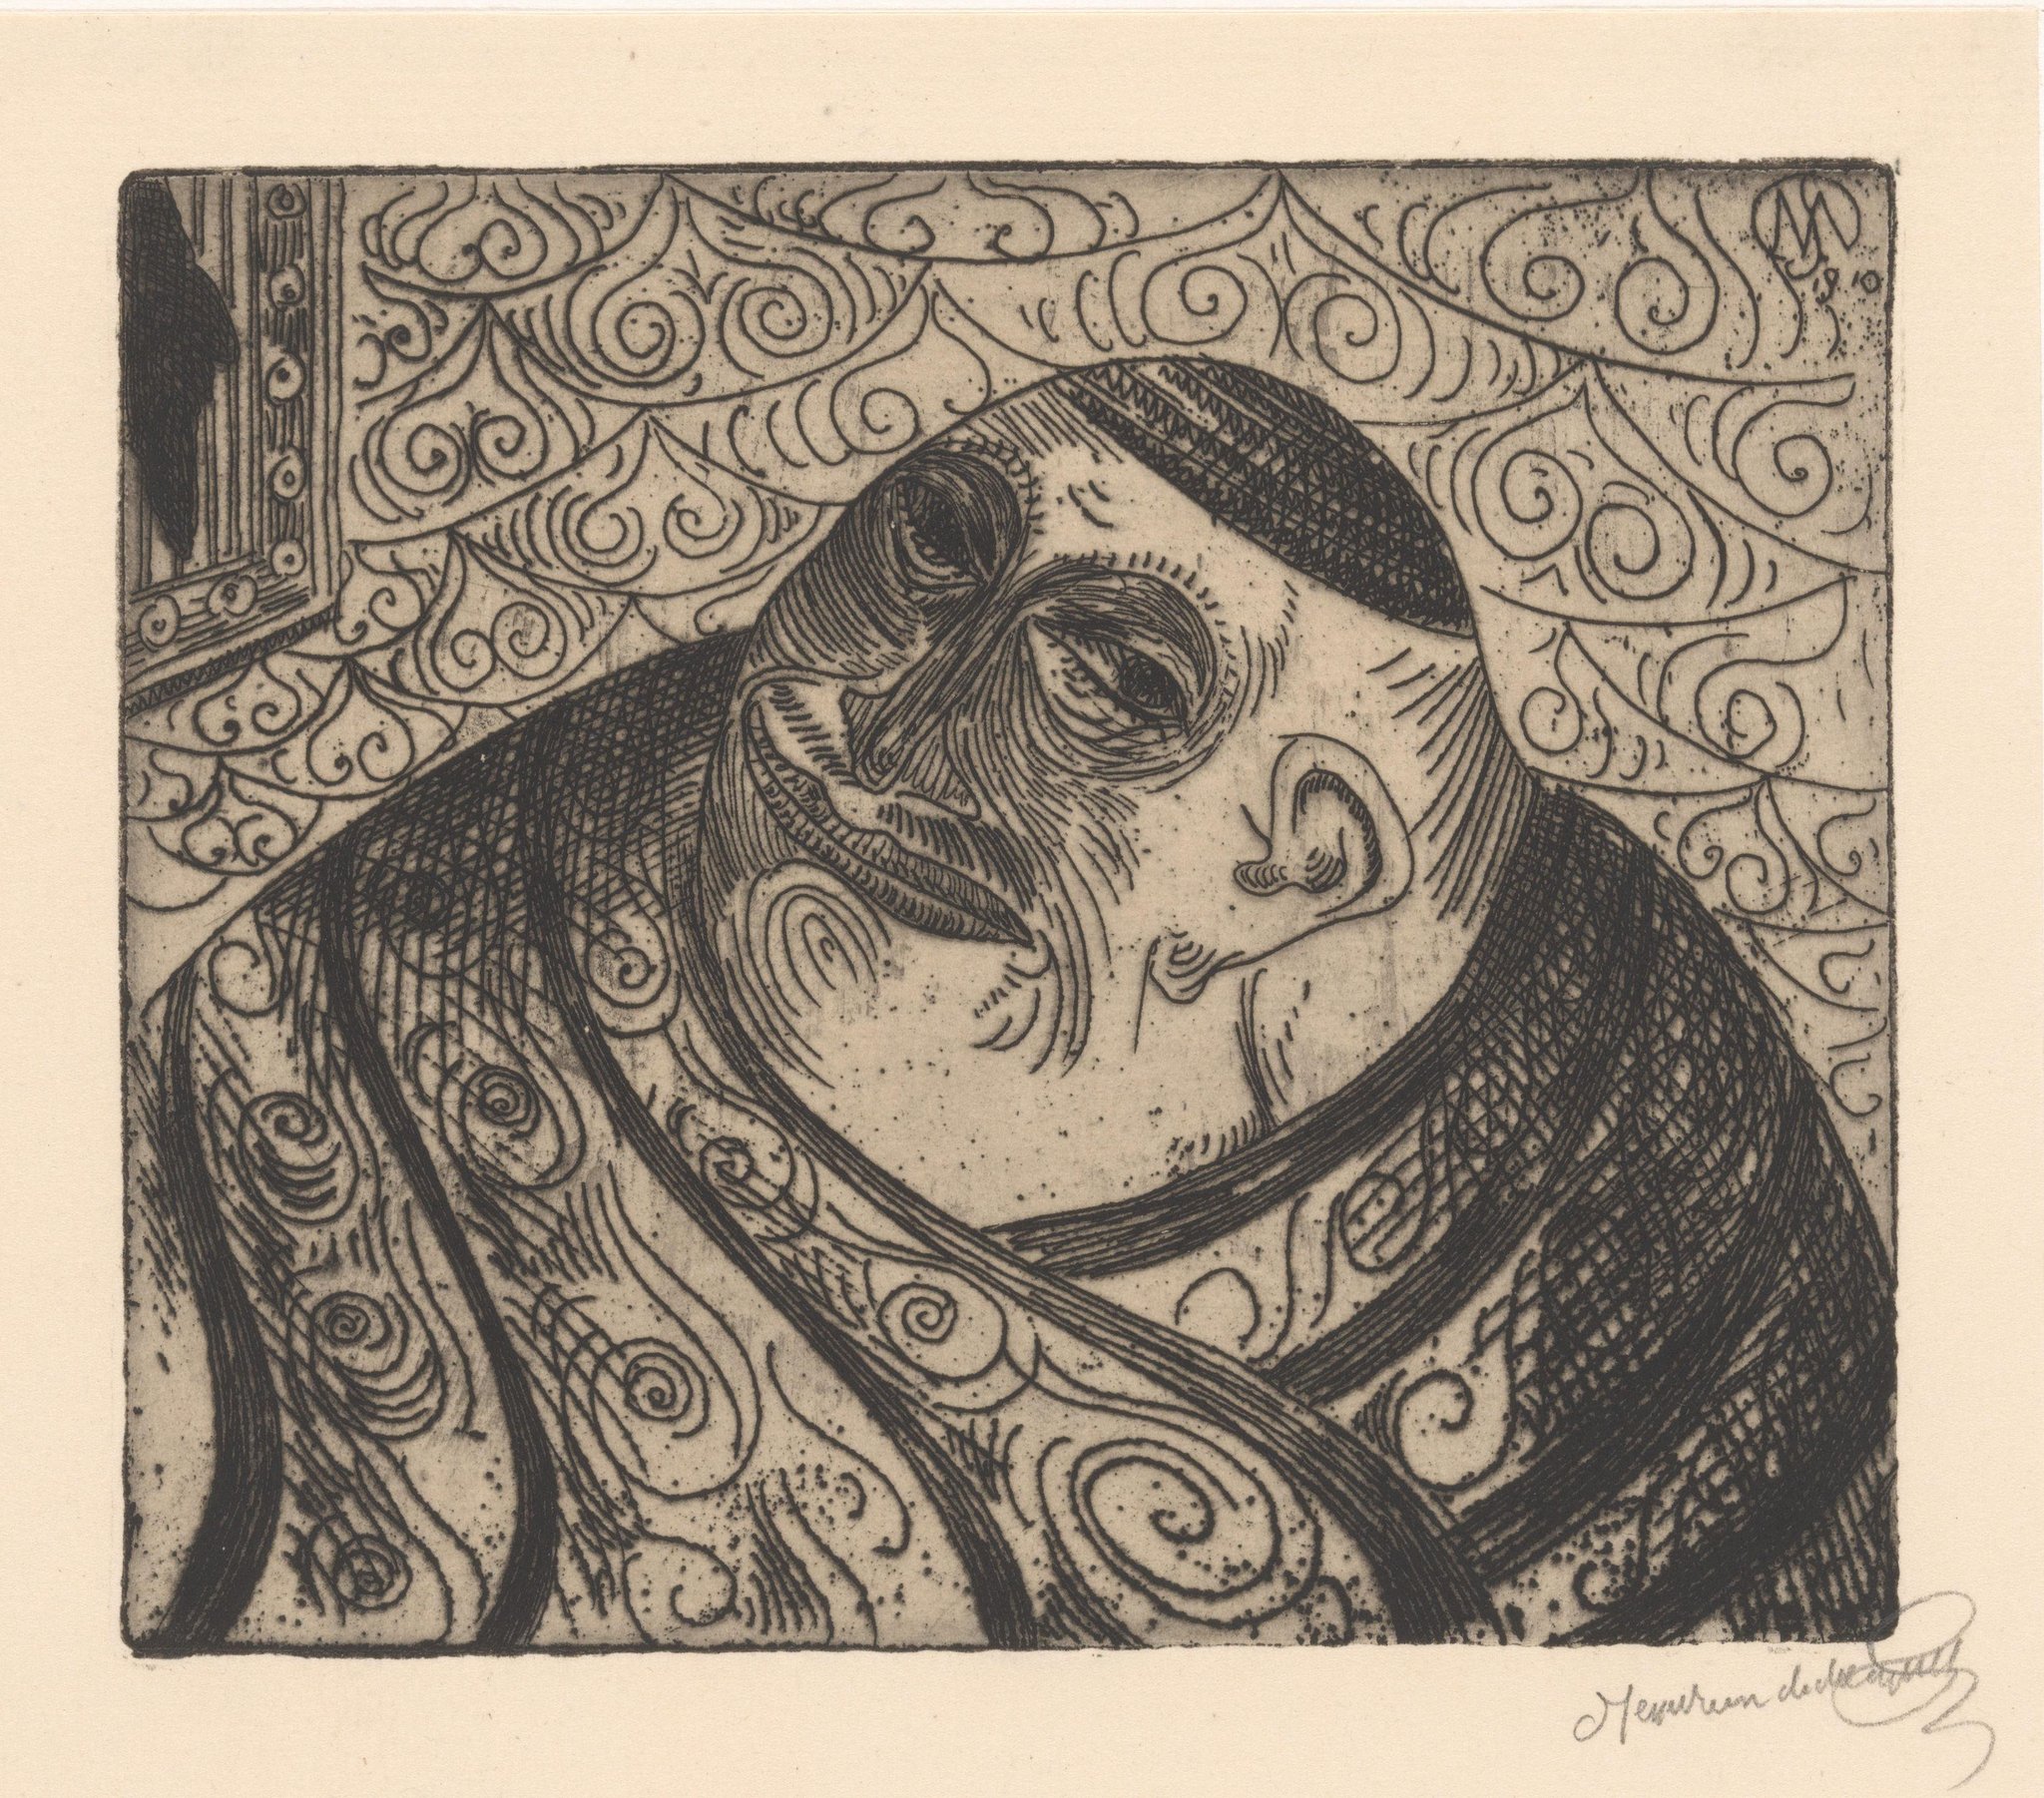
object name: print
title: Groteske verbeelding: man met keppeltje in rijk gedecoreerde omgeving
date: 1910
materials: paper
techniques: etching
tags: head-gear: cap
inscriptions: collector's mark: Lugt 2228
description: Man met brede mond en een keppel op het hoofd. Hij draagt een gestreepte mantel.